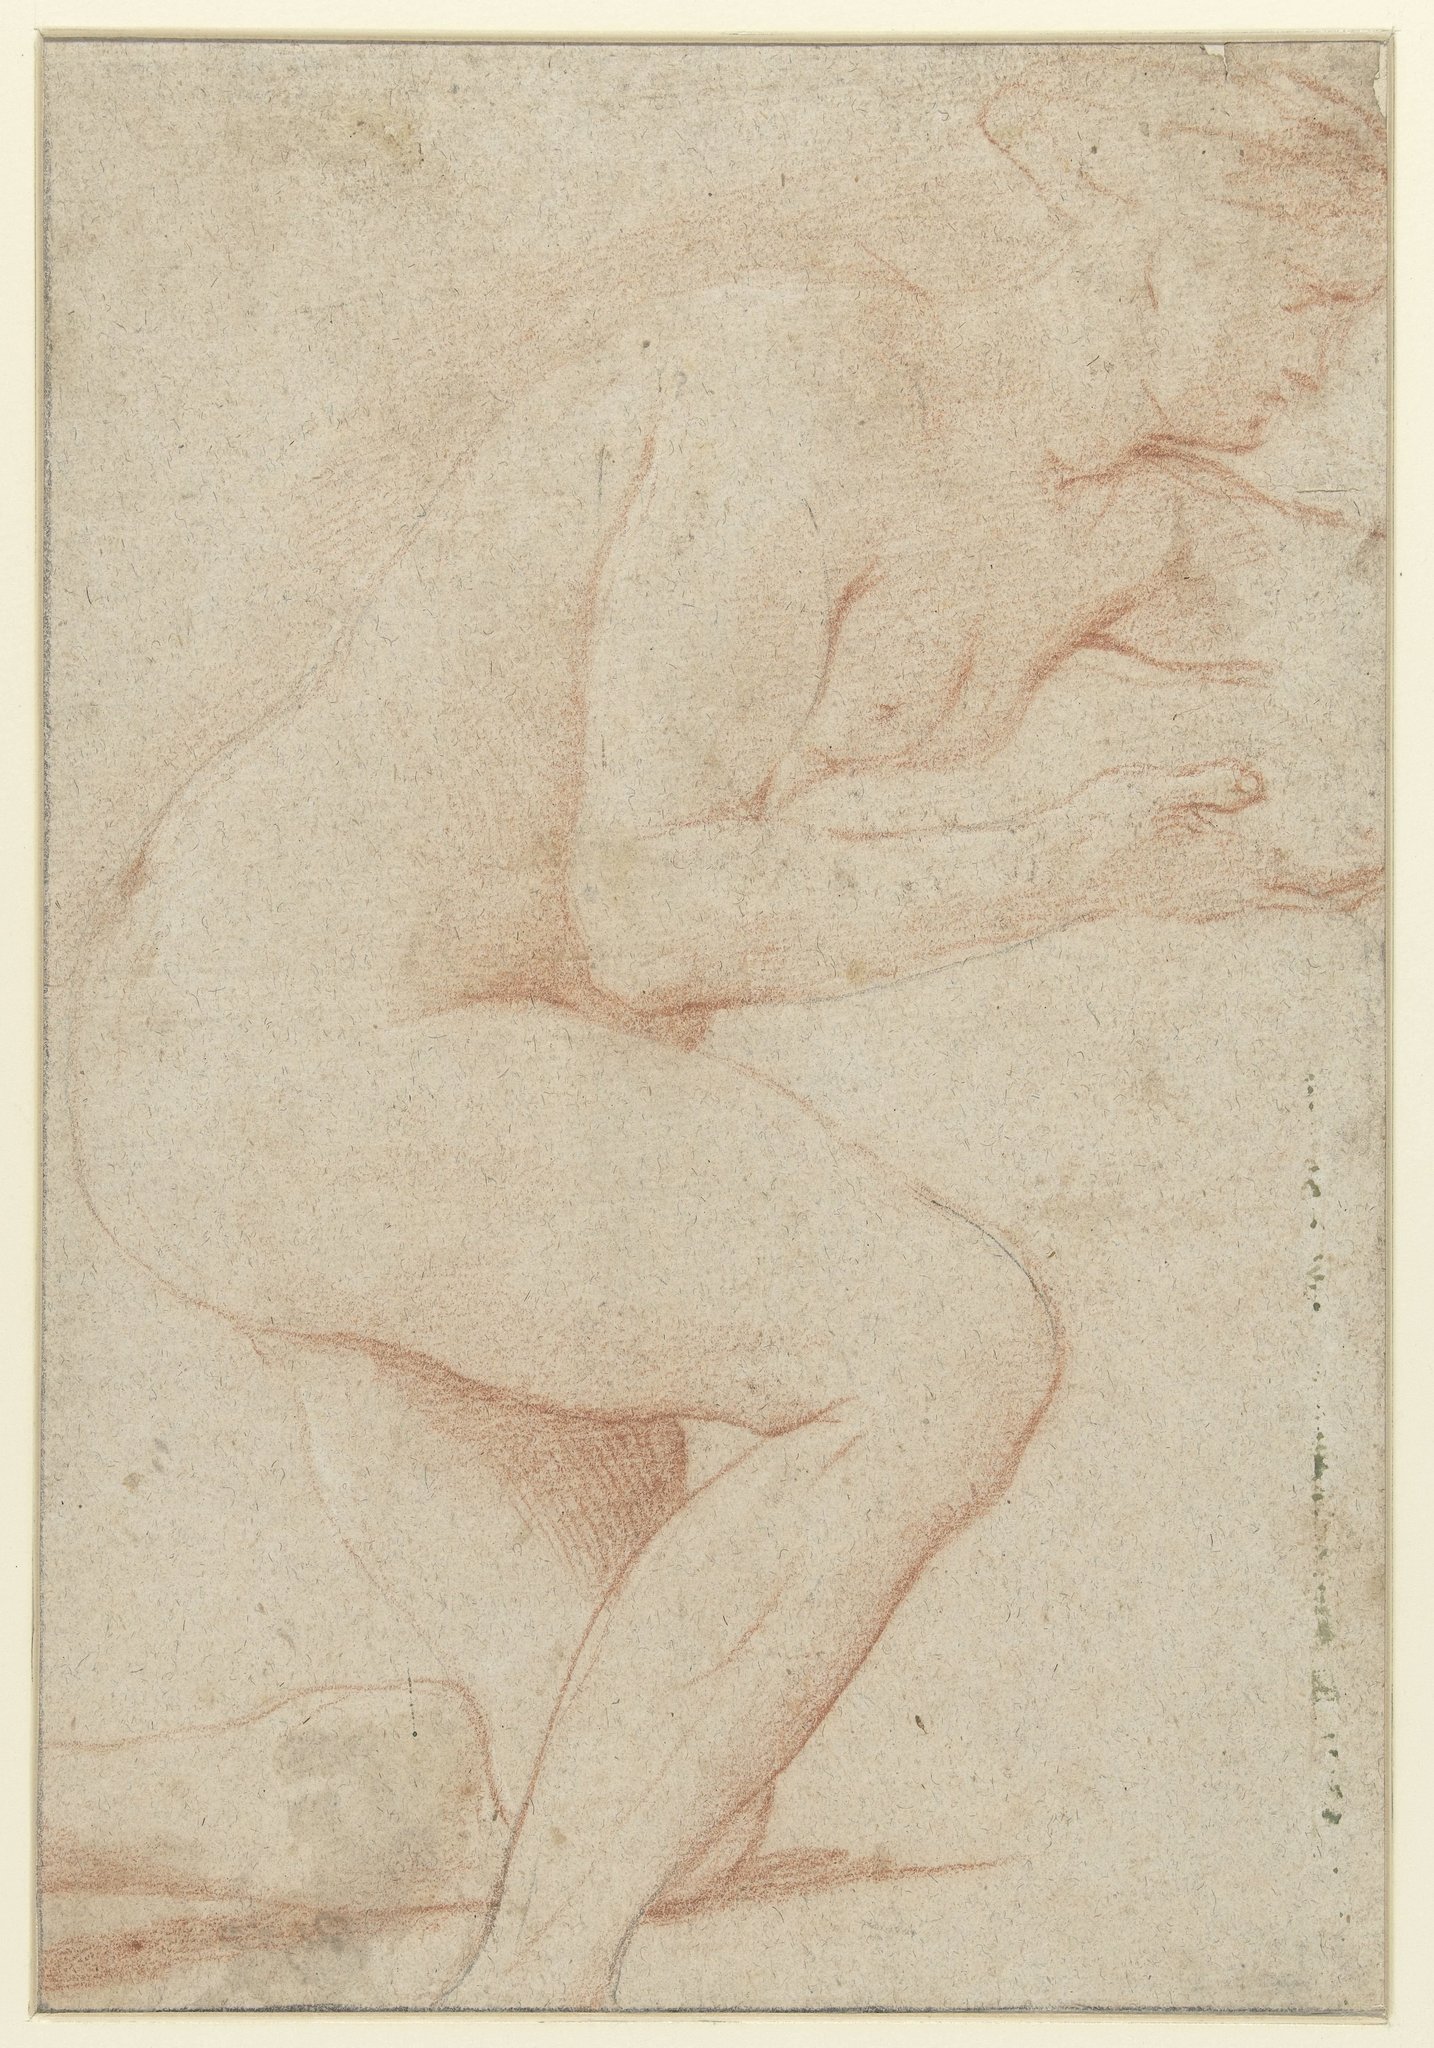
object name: drawing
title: Studie van vrouwelijk naakt, steunend op de knie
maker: jean françois pierre peyron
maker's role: draughtsman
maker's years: 1744-1814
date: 1754-1814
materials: chalk, paper, pencil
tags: kneeling figure - aa - female human figure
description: Studie van vrouwelijk naakt, naar rechts voorover buigend en steunend op de linkerknie.